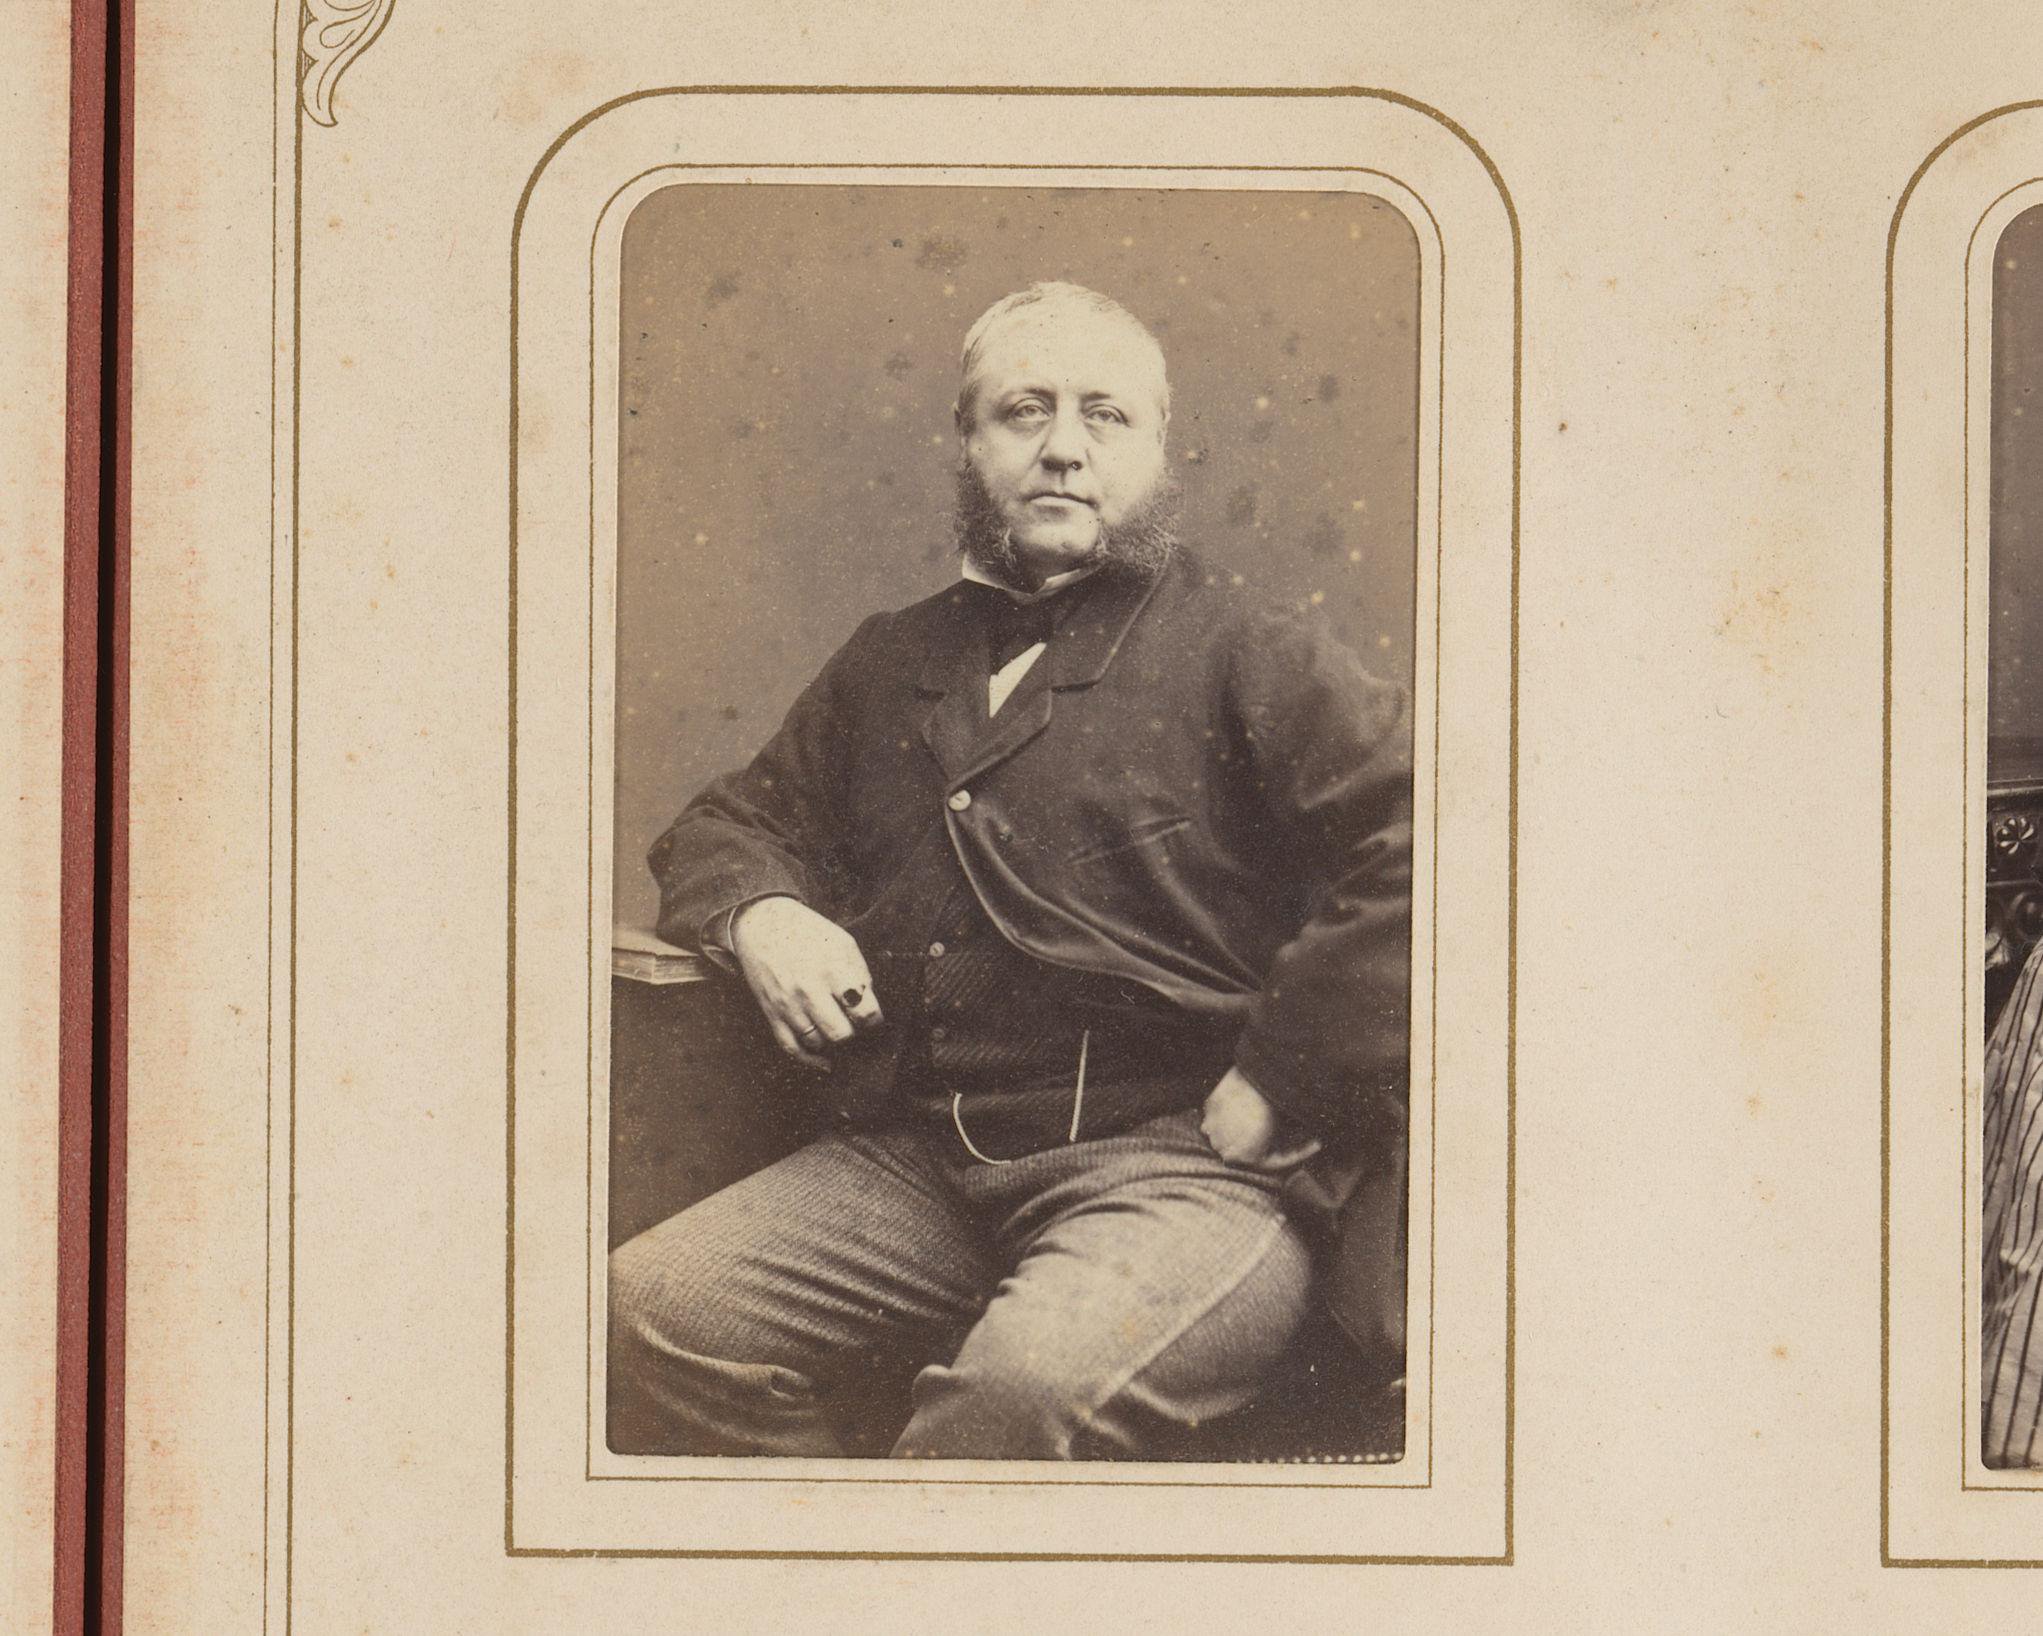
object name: photograph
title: Portret van een zittende man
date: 1862-1900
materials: cardboard, photographic support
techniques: albumen print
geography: amsterdam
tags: sitting figure, historical persons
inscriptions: inscription: ‘PHOTOGr ATELIER/ WEGENER & MOTTU,/ KALVERSTRAAT/ Over den Heyligenweg D. 26/ AMSTERDAM’